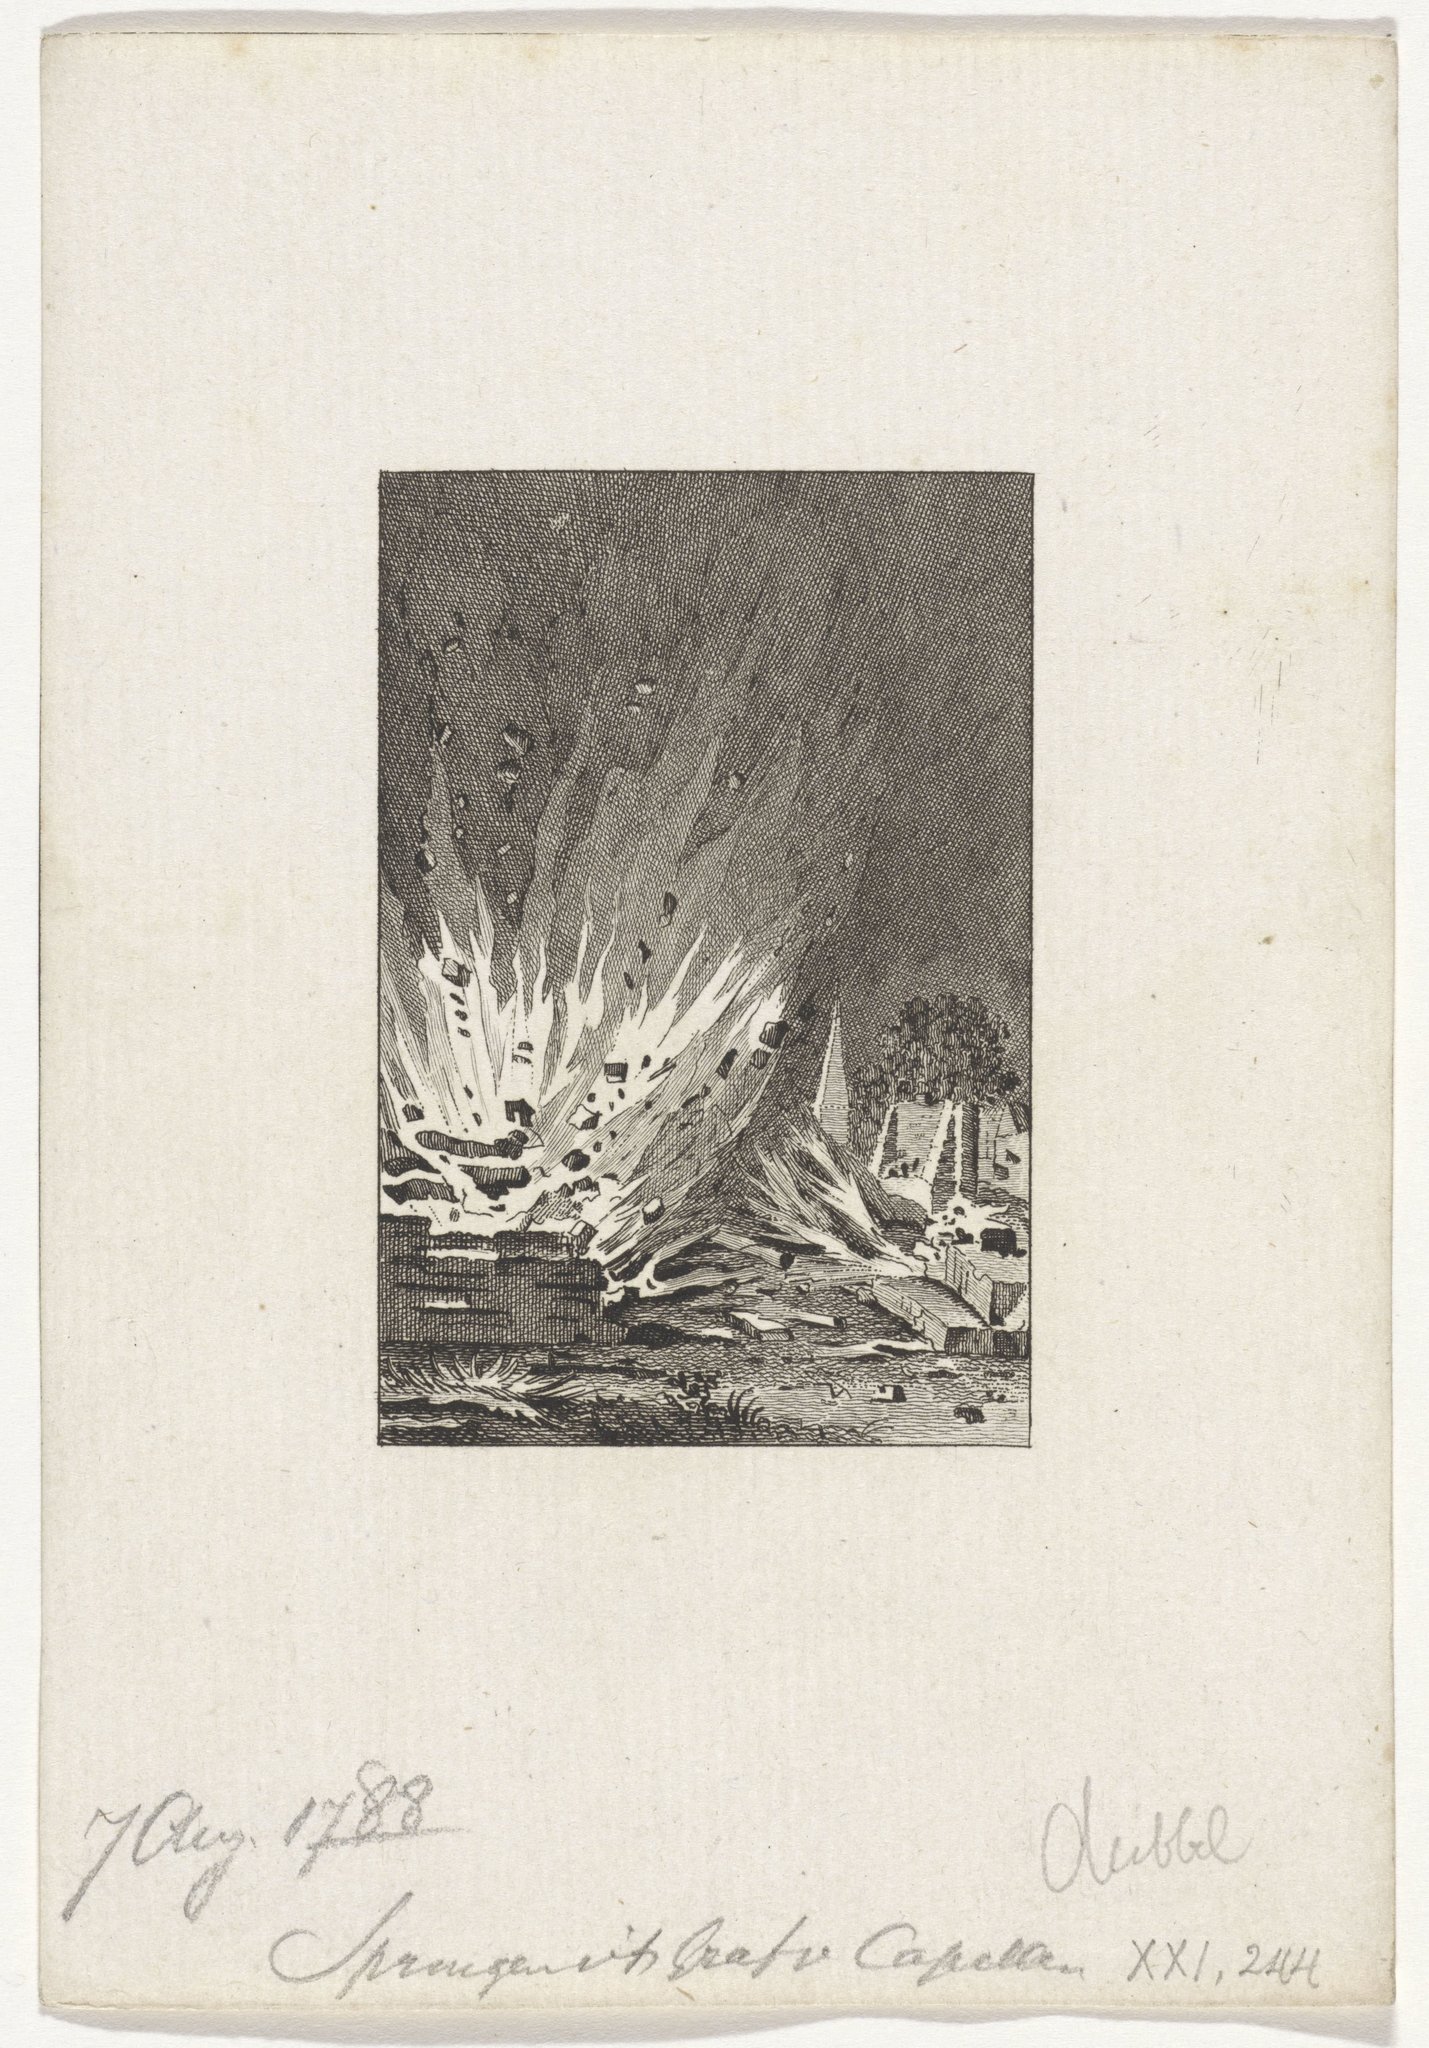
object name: history print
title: Opblazen van de begraafplaats van de familie Van der Capellen, 1788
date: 1783-1795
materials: paper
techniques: etching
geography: amsterdam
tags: joan derk van der capellen tot den pol, bomb-outrage, grave-building, monumental tomb, patriots (1780-1795)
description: Illustratie voor: J. Fokke. Geschiedenissen der Vereenigde Nederlanden voor de vaderlandsche jeugd. Amsterdam: Johannes Allart, 1783-1795, 25 delen. deel XXI pl. IX.